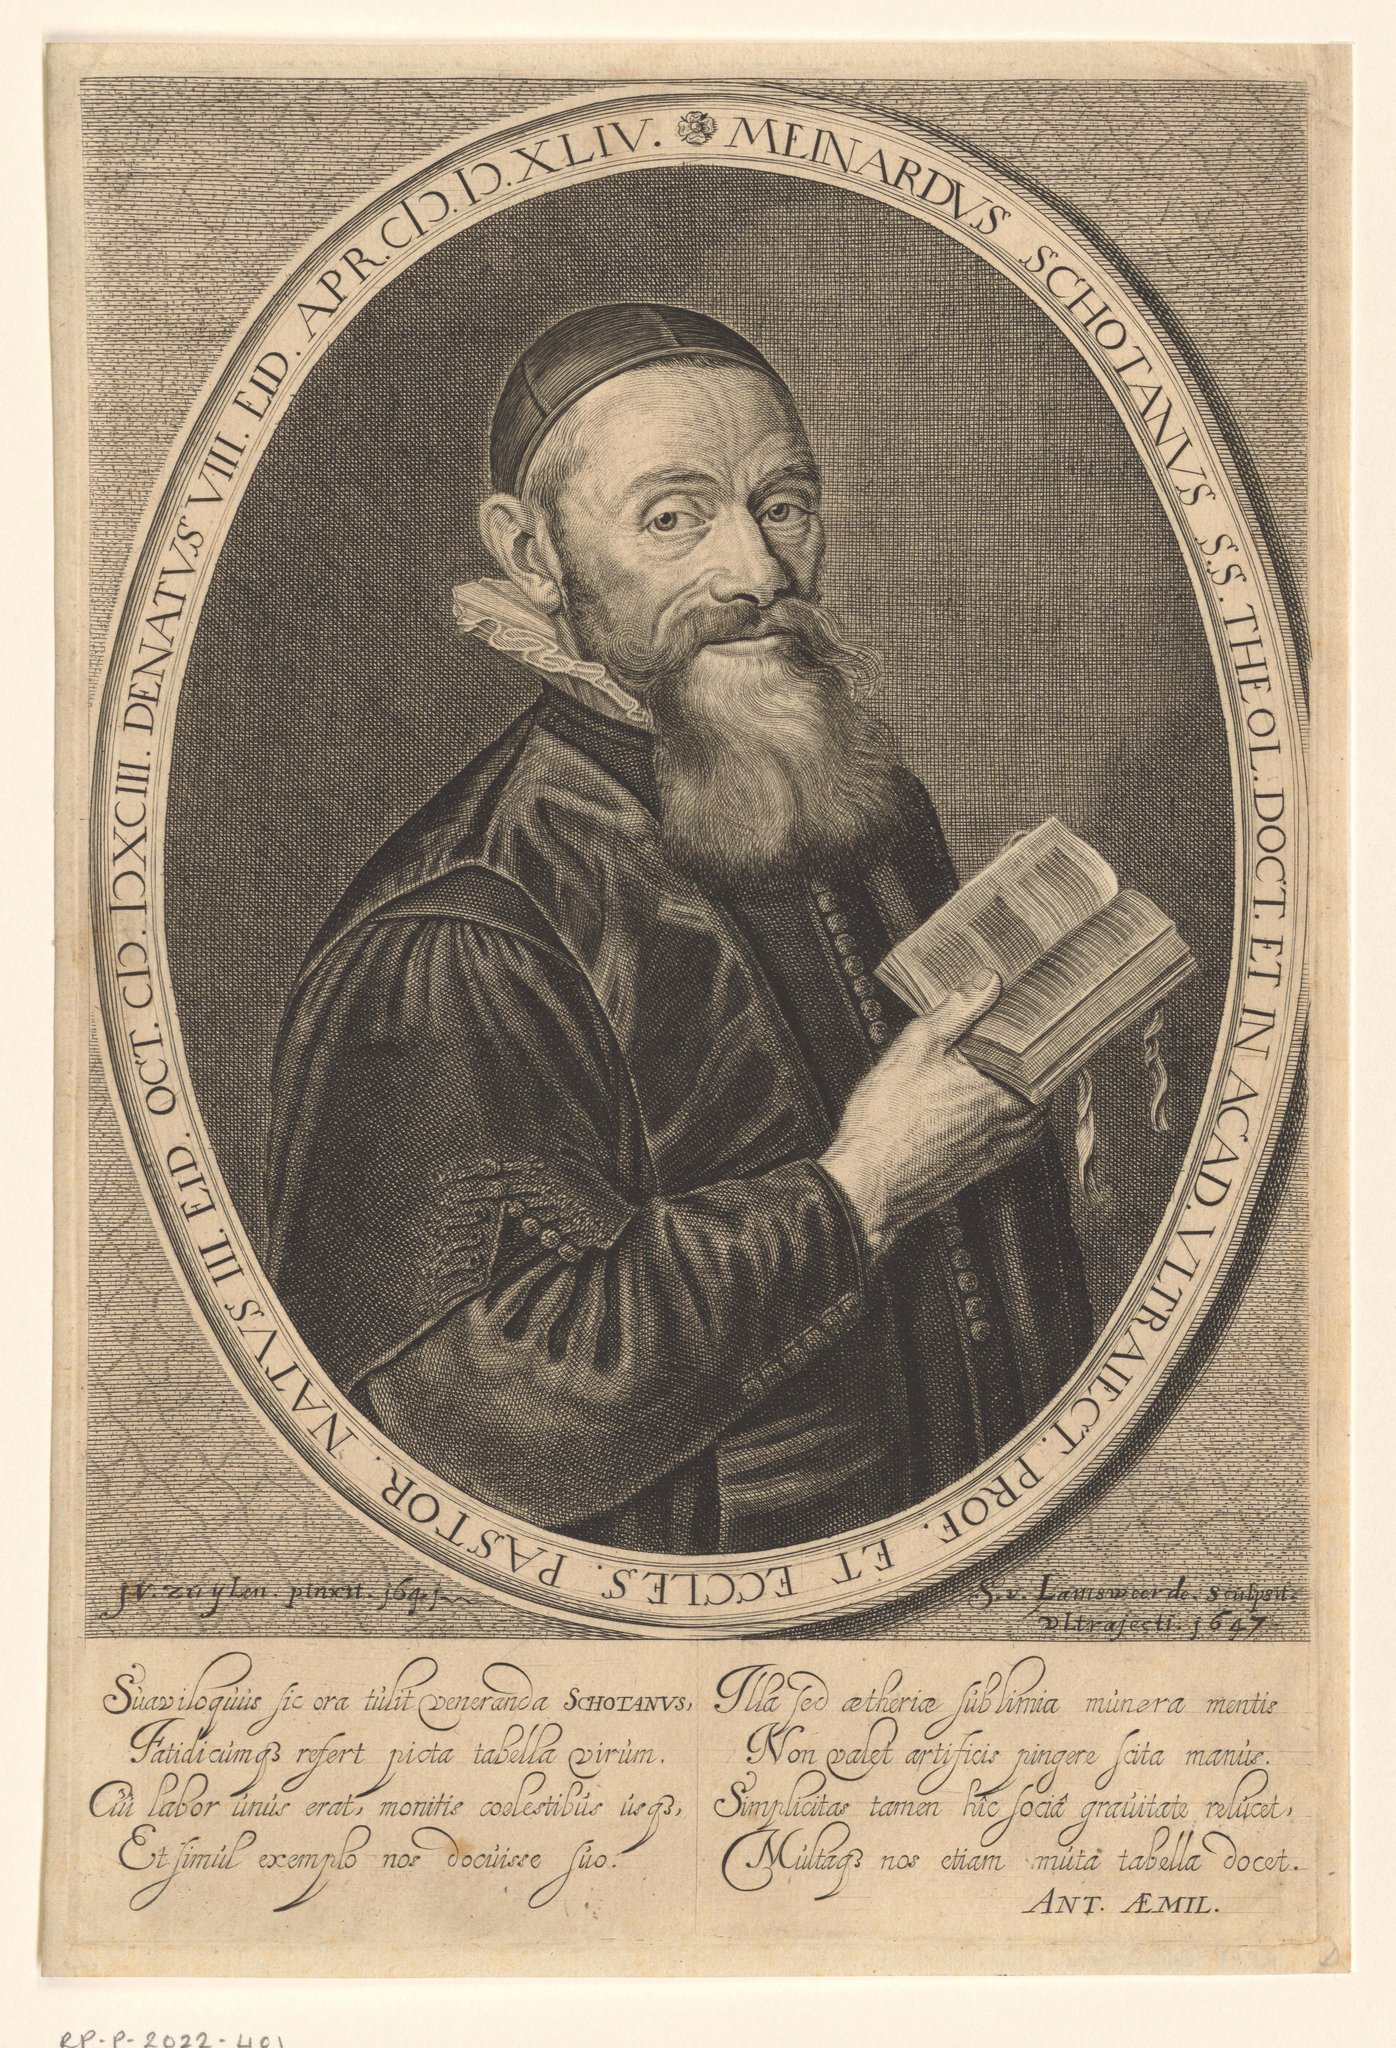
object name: print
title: Portret van Meinardus Schotanus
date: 1647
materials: paper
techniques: engraving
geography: utrecht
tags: theologian, historical persons, book - mm - book open